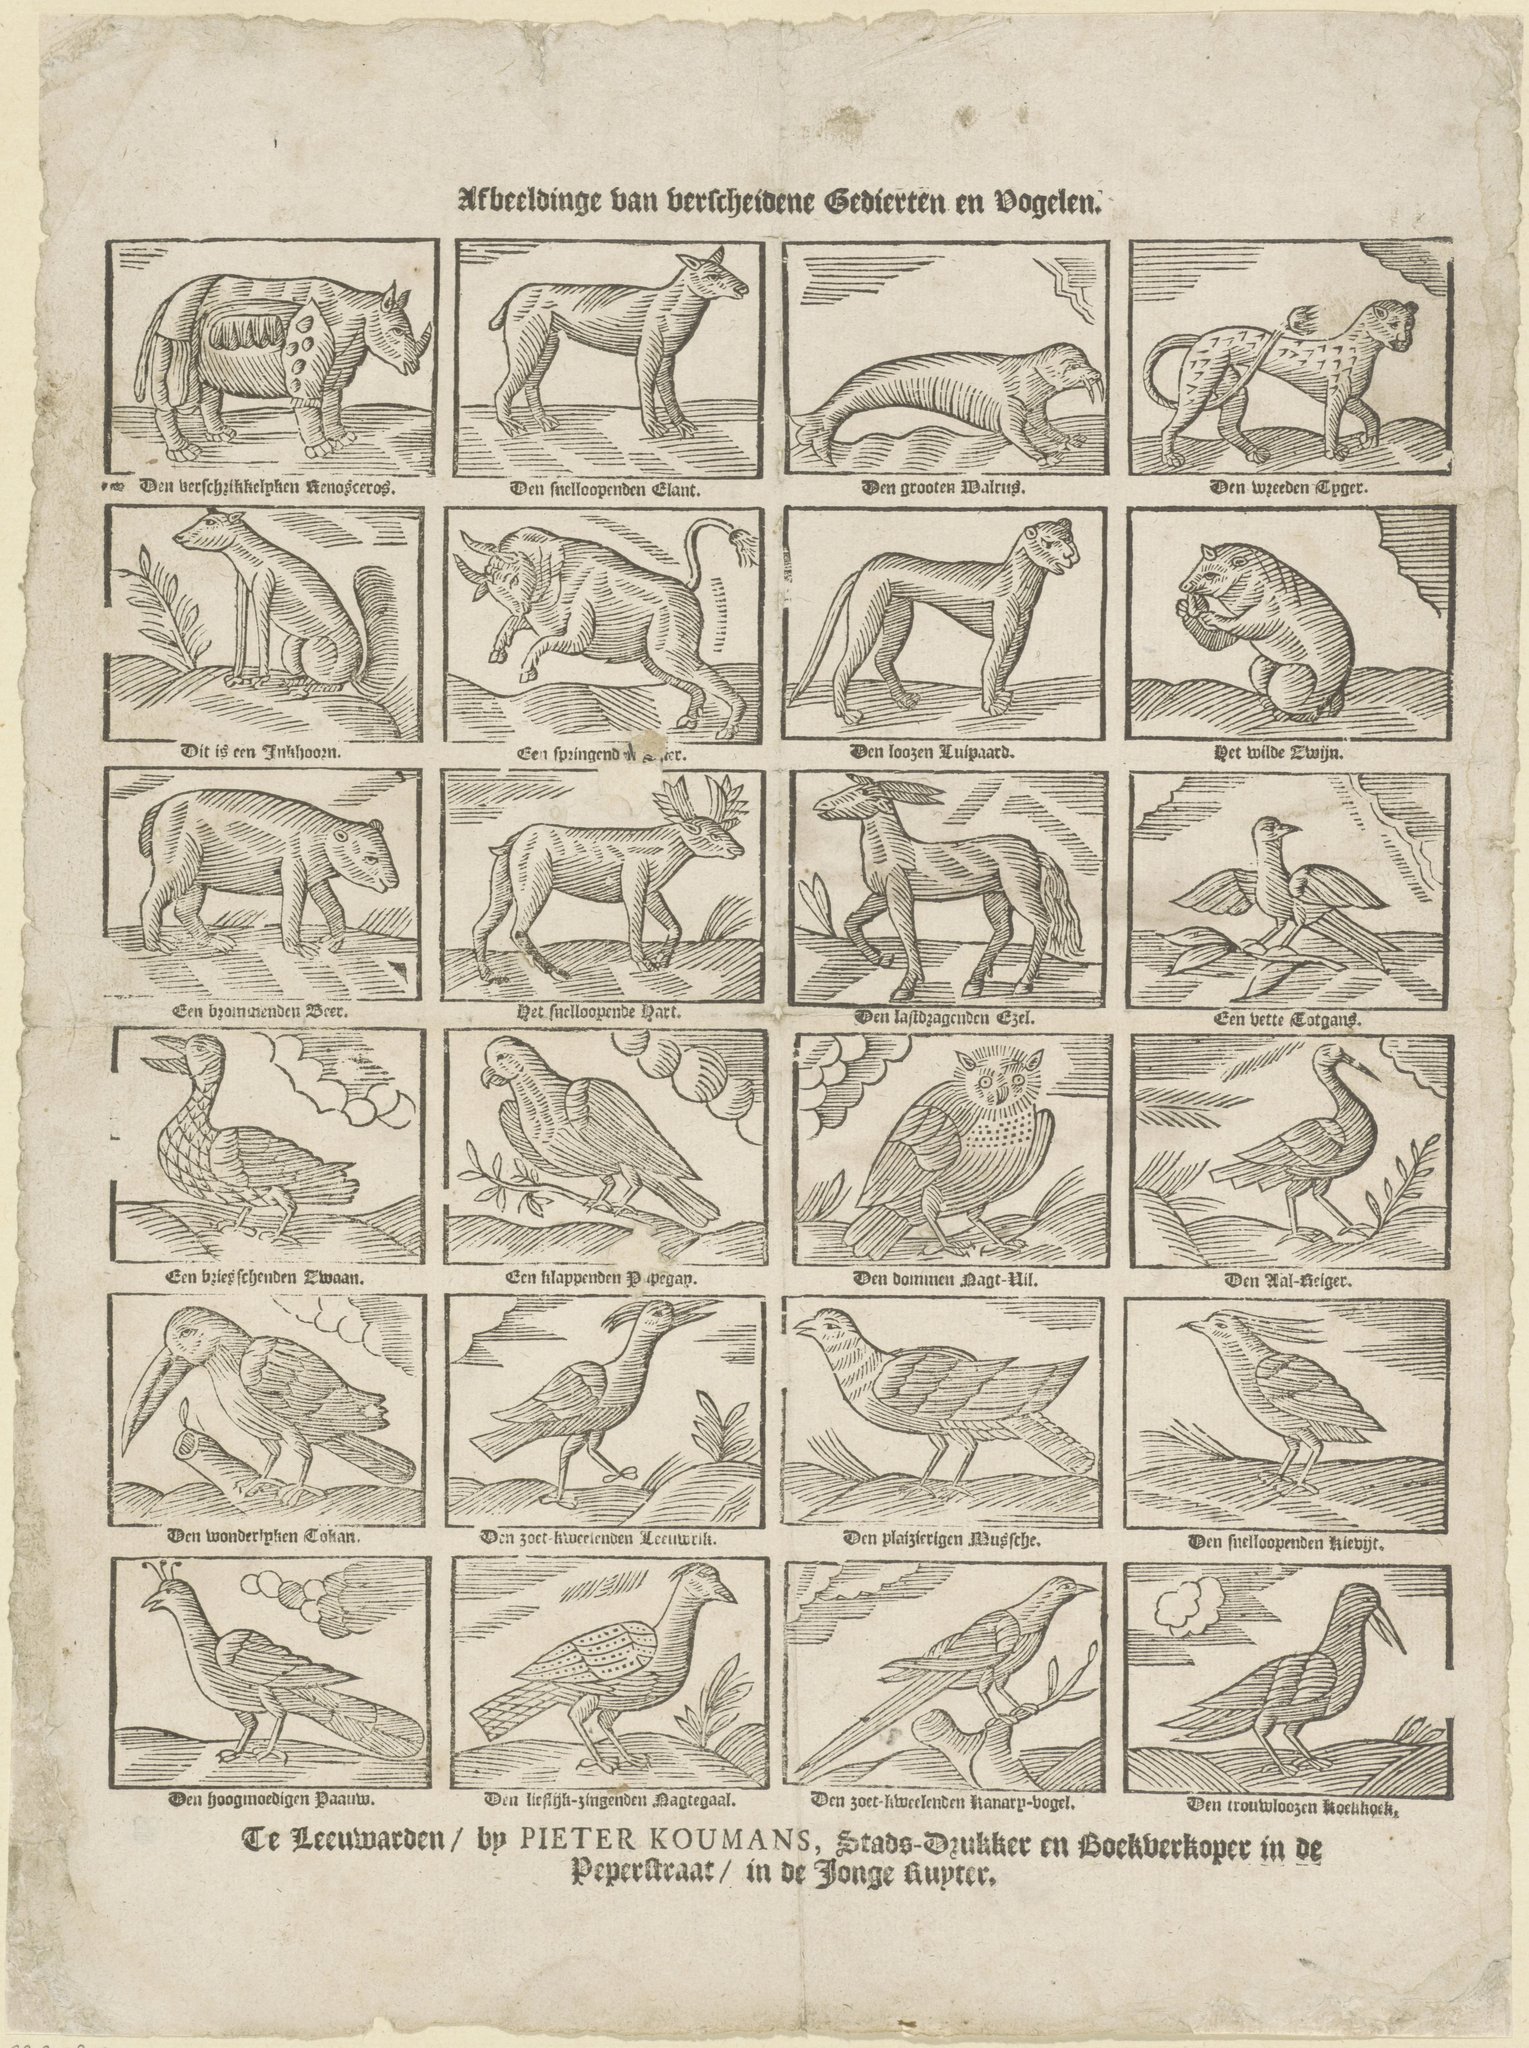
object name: popular print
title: Afbeeldinge van verscheidene gedierten en vogelen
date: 1722-1768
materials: paper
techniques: letterpress printing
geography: leeuwarden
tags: animals, birds, hoofed animals: rhinoceros, swimming mammals: walrus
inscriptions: collector's mark: Lugt 2760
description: Blad met 24 voorstellingen van dieren, waaronder een neushoorn, een walrus, een uil en een koekoek. Onder elke afbeelding een onderschrift.